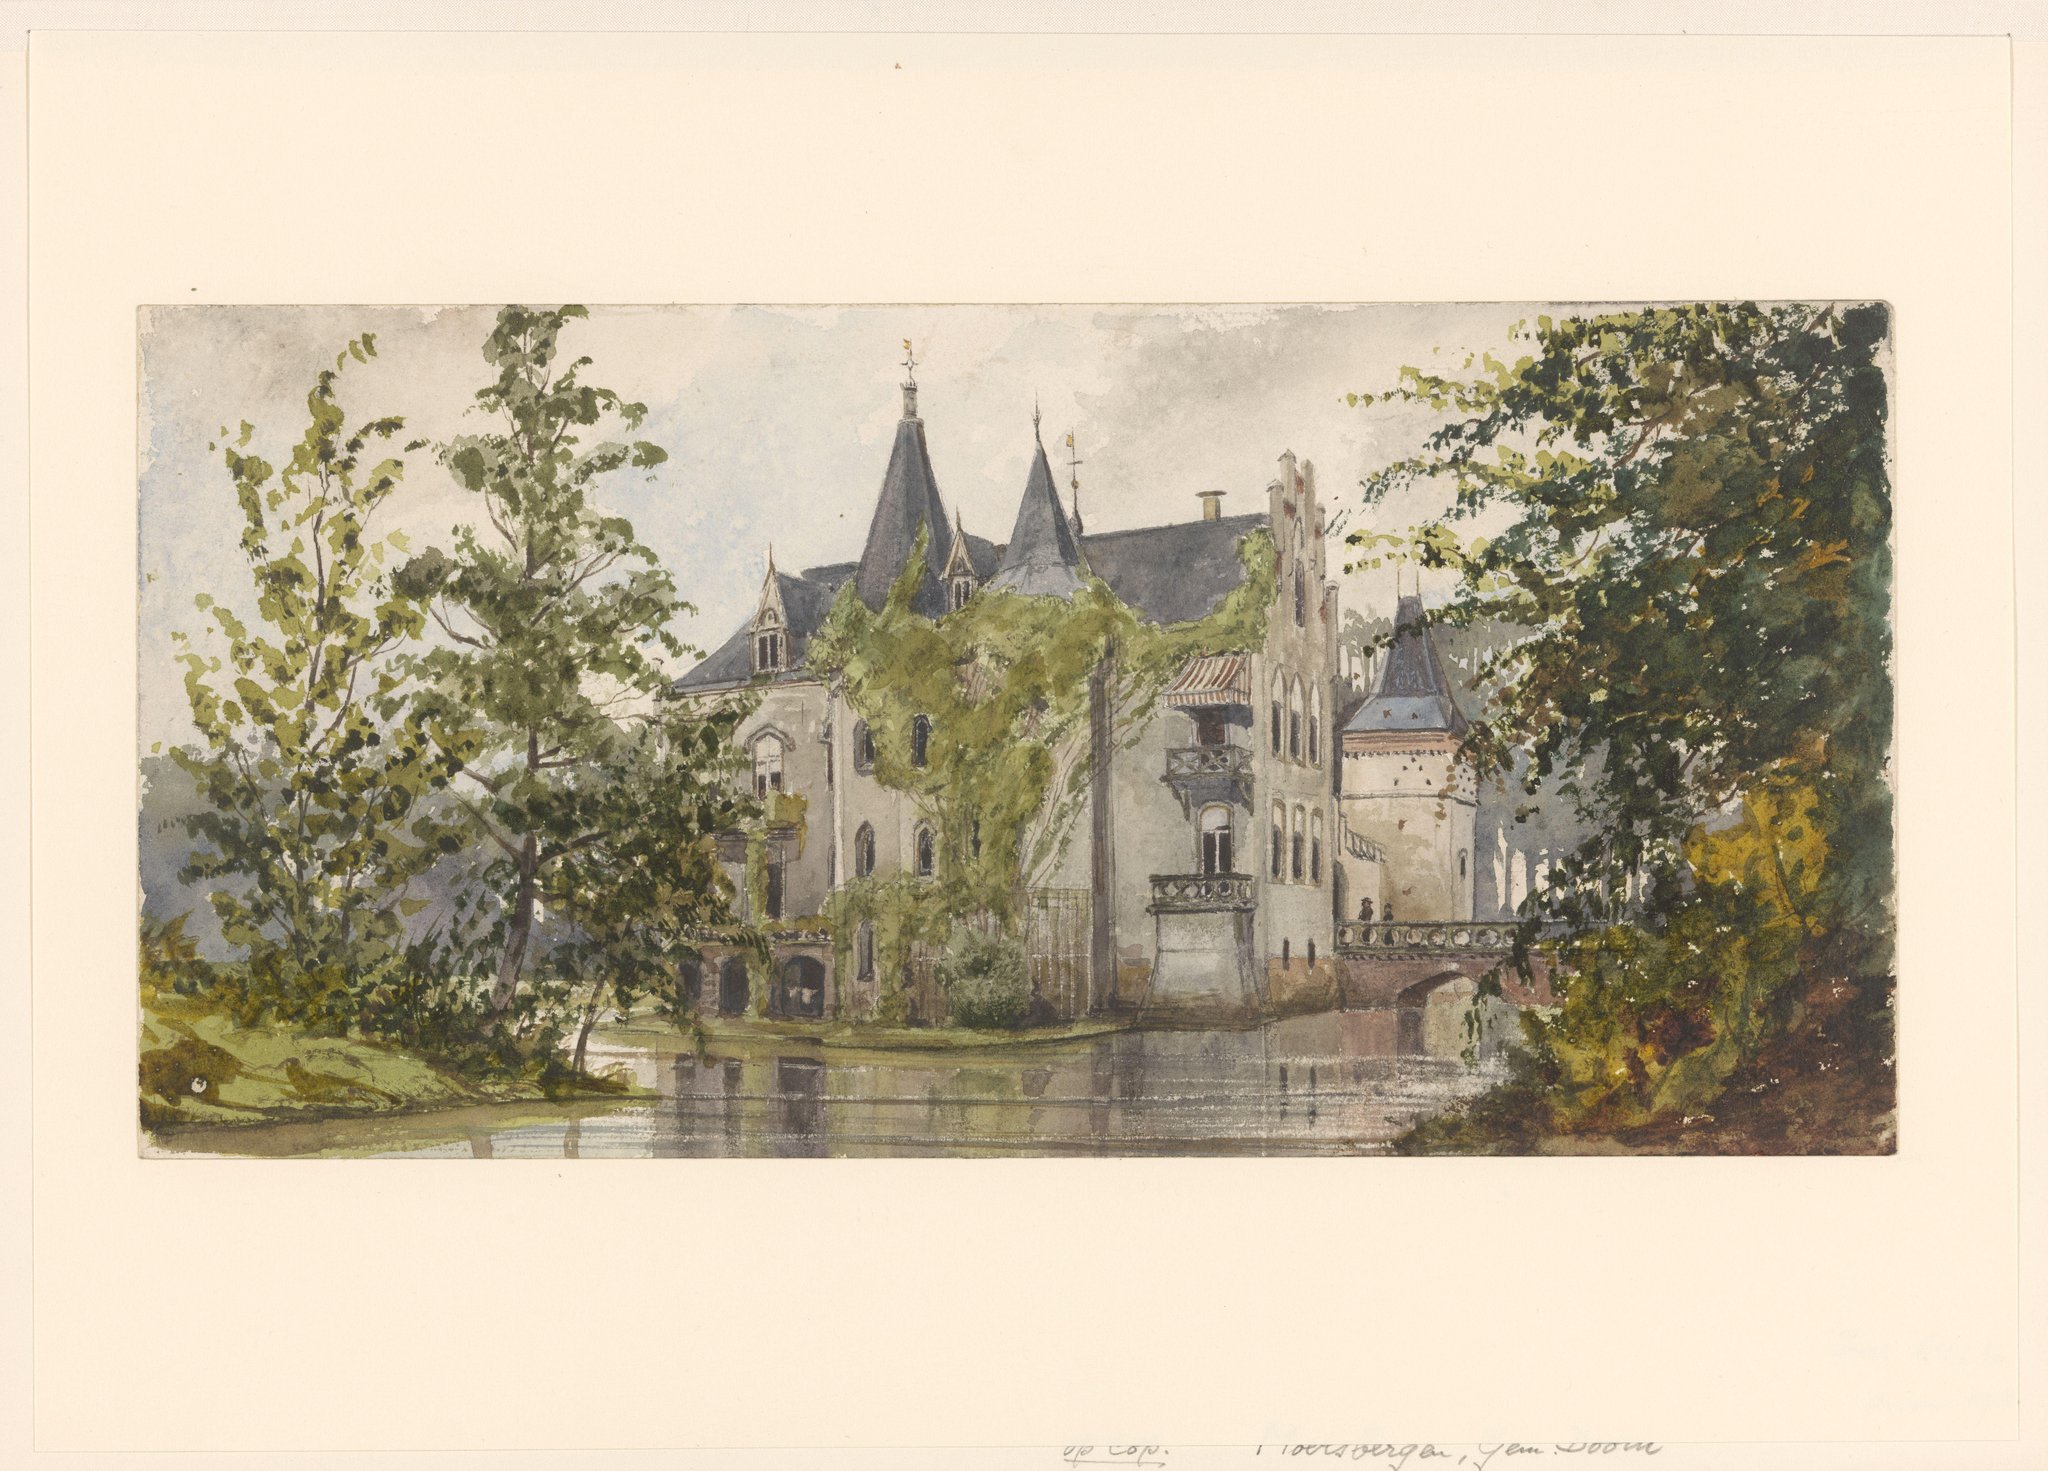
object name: drawing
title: Kasteel Moersbergen bij Doorn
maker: Anonymous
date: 1823-1927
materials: paper, pencil, watercolor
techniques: brush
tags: bridge with structure, i.e. cover or buildings, castle, kasteel moersbergen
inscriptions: inscription: ‘Kasteel Moersbergen bij Doorn’, collector's mark: Lugt 2228